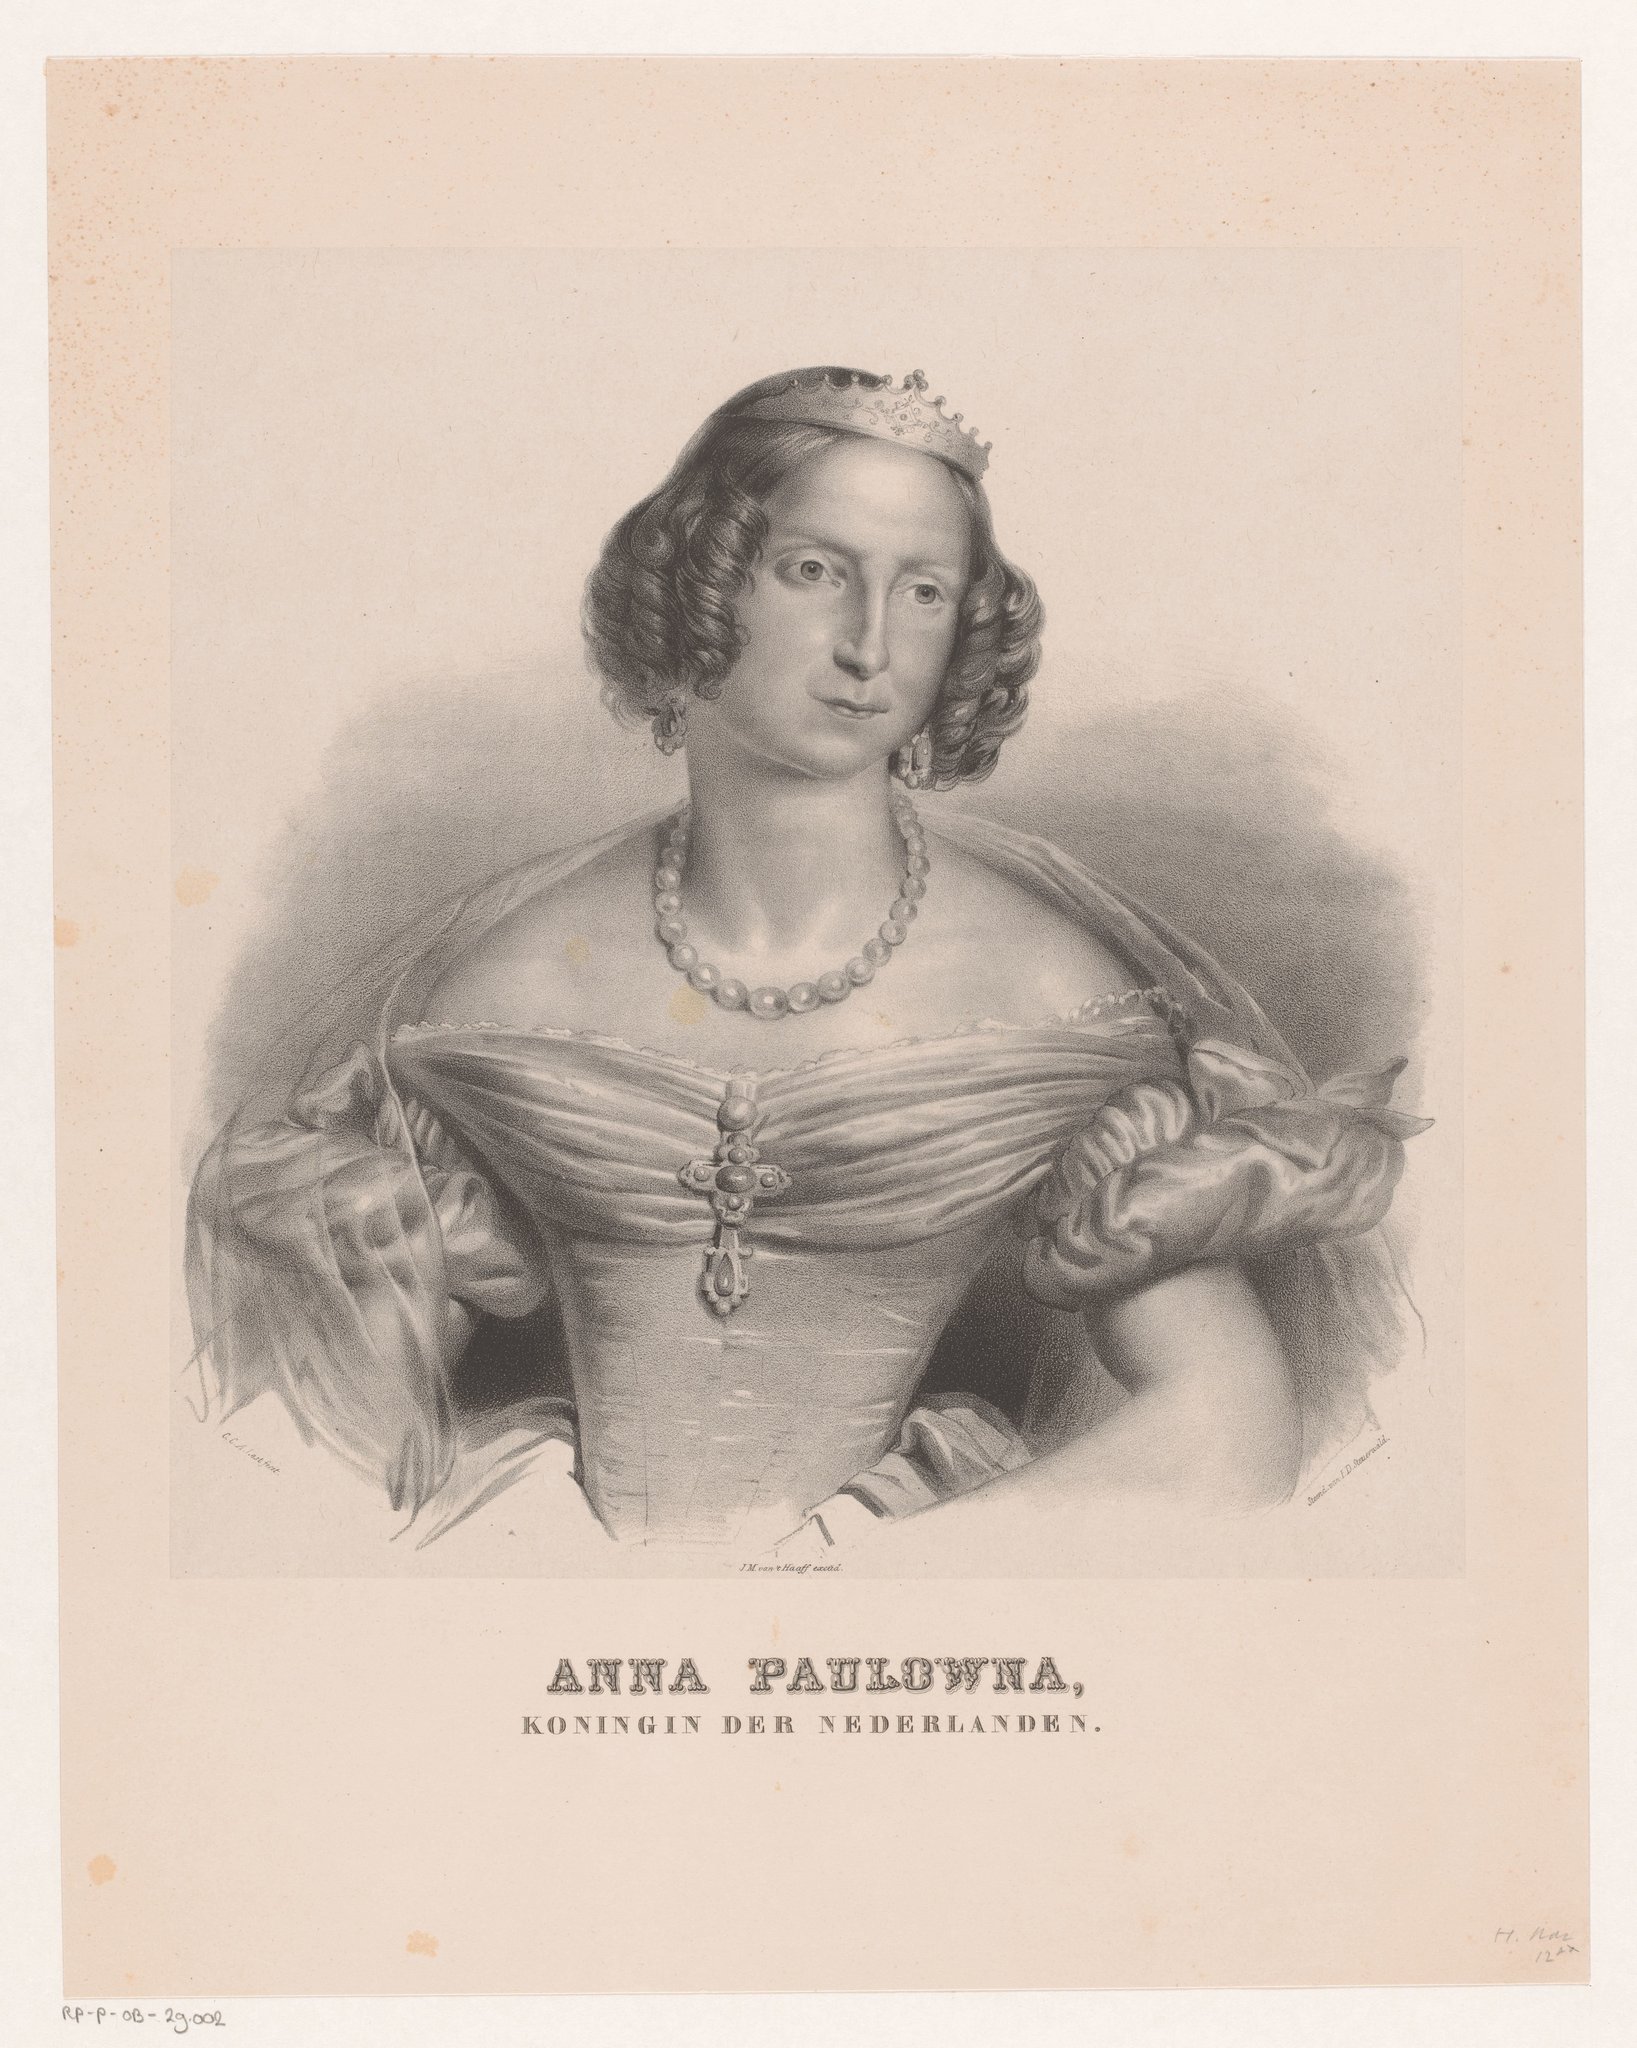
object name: print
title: Anna Paulowna, konigin der Nederlanden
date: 1822-1863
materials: paper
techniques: lithograph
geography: the hague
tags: the hague, anna paulowna romanowa, historical persons - bb - woman (+ (full) bust portrait), pearl; pearl necklace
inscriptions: collector's mark: Lugt 2228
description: De geportretteerde draagt een jurk met ontblote schouders, een parelketting, oorbellen en een tiara.